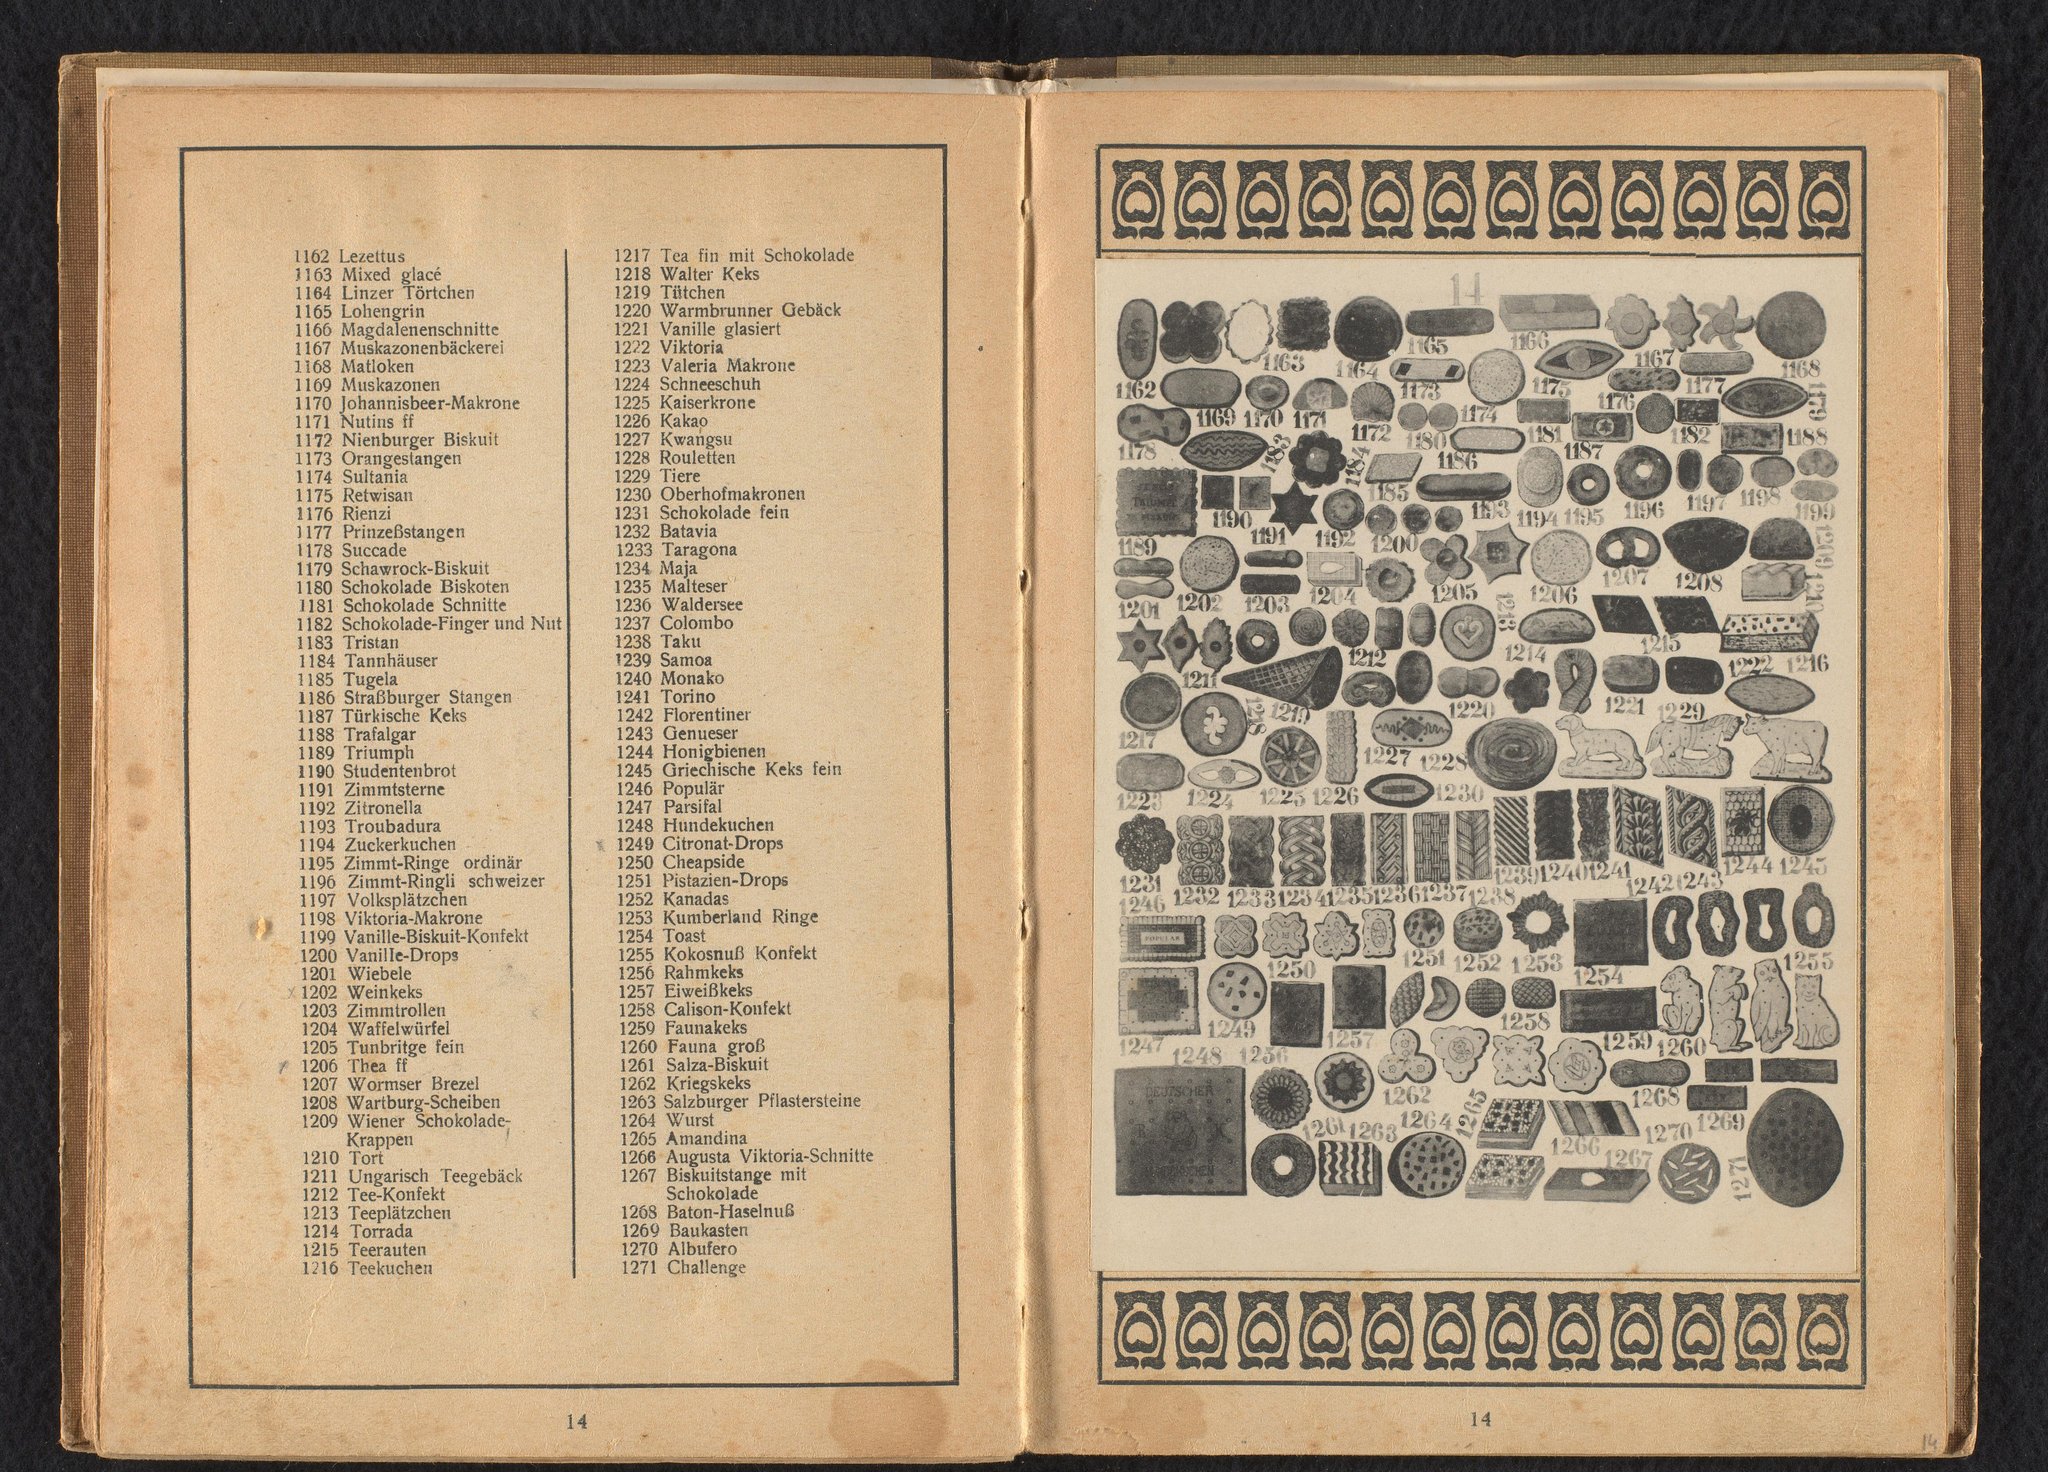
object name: photomechanical print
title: Verschillende Engelse koekjes en biscuits als voorbeeld bij recepten 1162-1271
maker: Anonymous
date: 1900-1905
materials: paper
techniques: photograph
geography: bad langensalza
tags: pastry cook, moulds for biscuits, biscuits